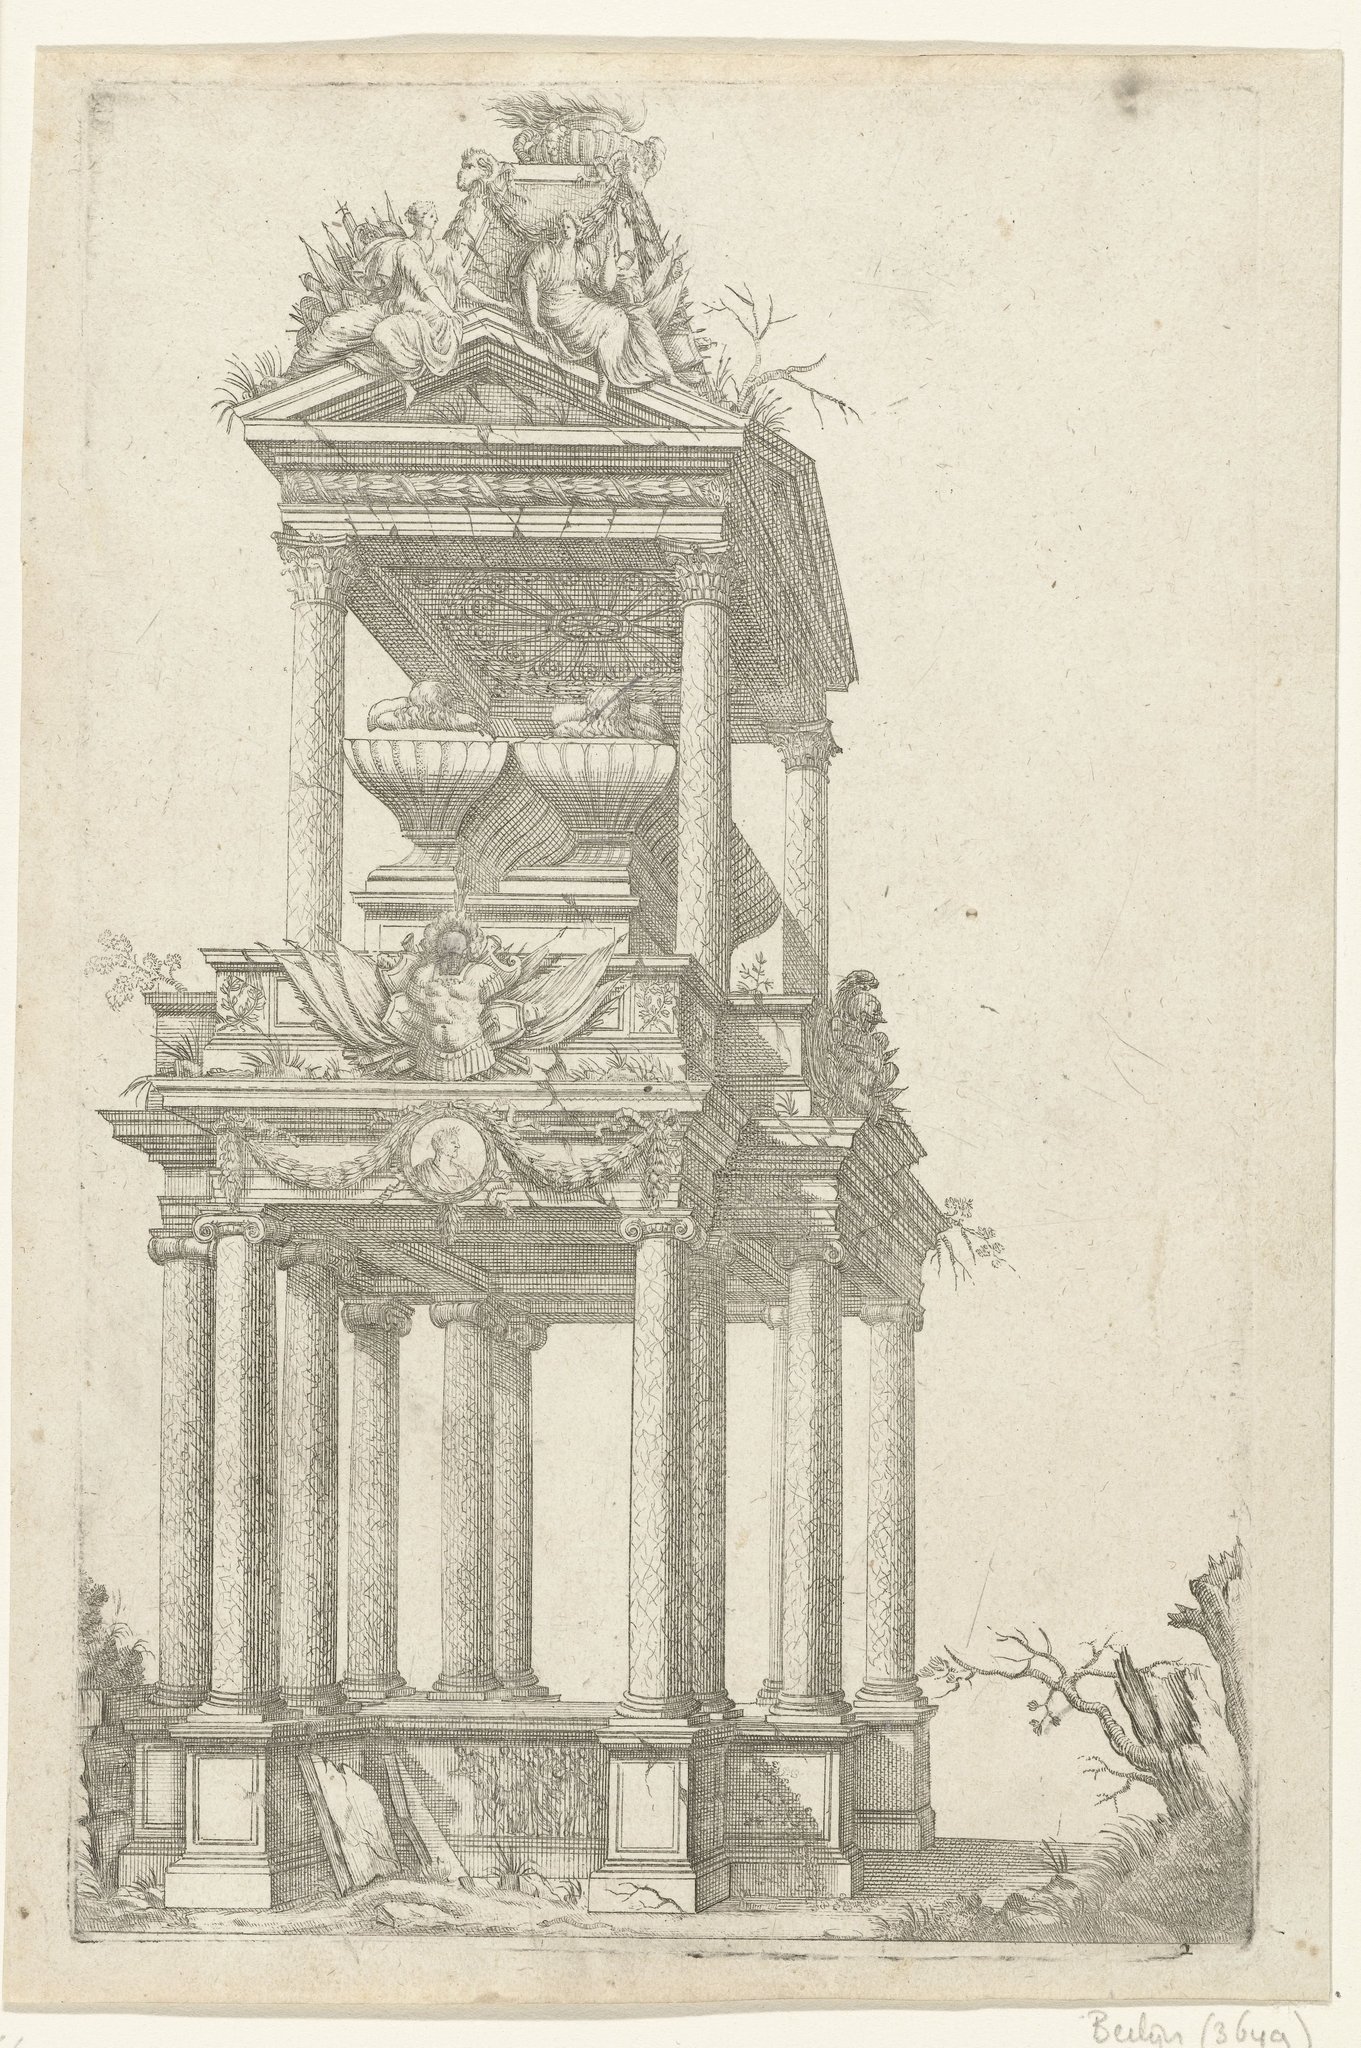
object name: print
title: Grafmonument met twee verdiepingen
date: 1629-1716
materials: paper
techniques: engraving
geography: paris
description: Op de bovenste verdieping staan twee kisten bekroond met een brandende urn. Uit eerste editie.